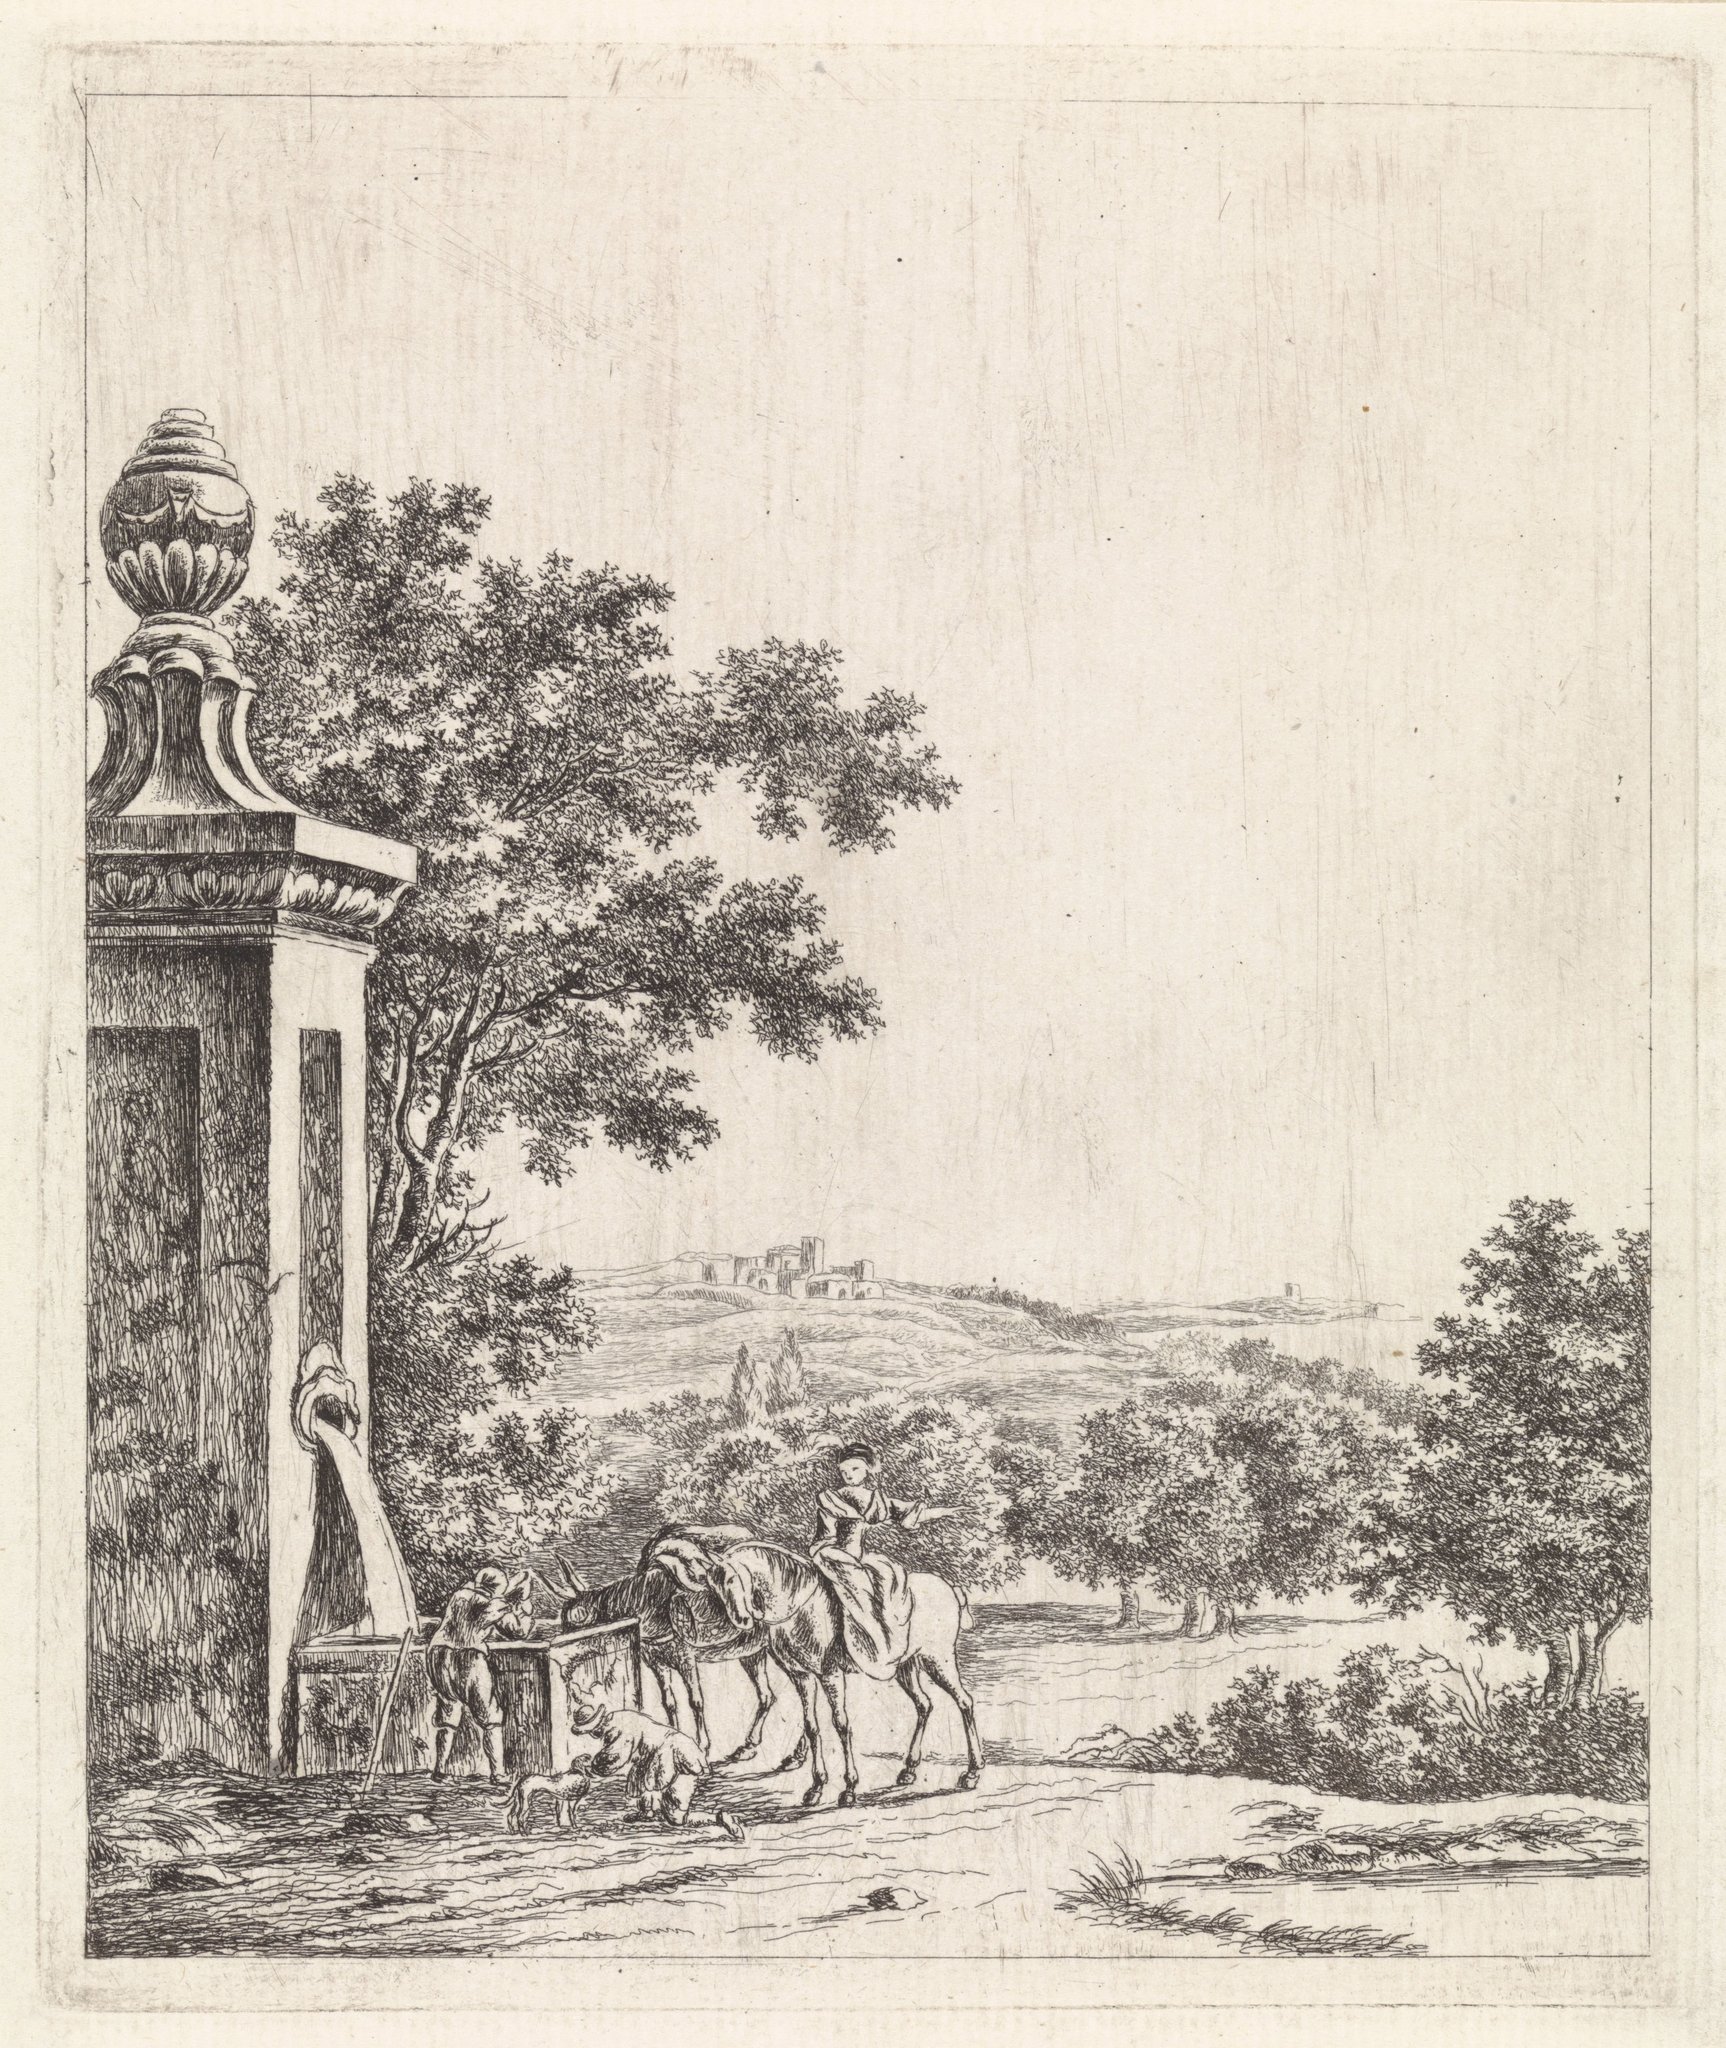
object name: print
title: Landschap met fontein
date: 1761-1784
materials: paper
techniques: etching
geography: leiden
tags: pastorals, arcadian scenes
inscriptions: collector's mark: Lugt 2228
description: Heuvelachtig landschap met fontein. Een man, op de rug gezien, en een ezel drinken uit de fontein. Naast de ezel een vrouw, zittend op een paard. Voor de fontein een gehurkte man met een hond. Vóór de puntige berg op de achtergrond.